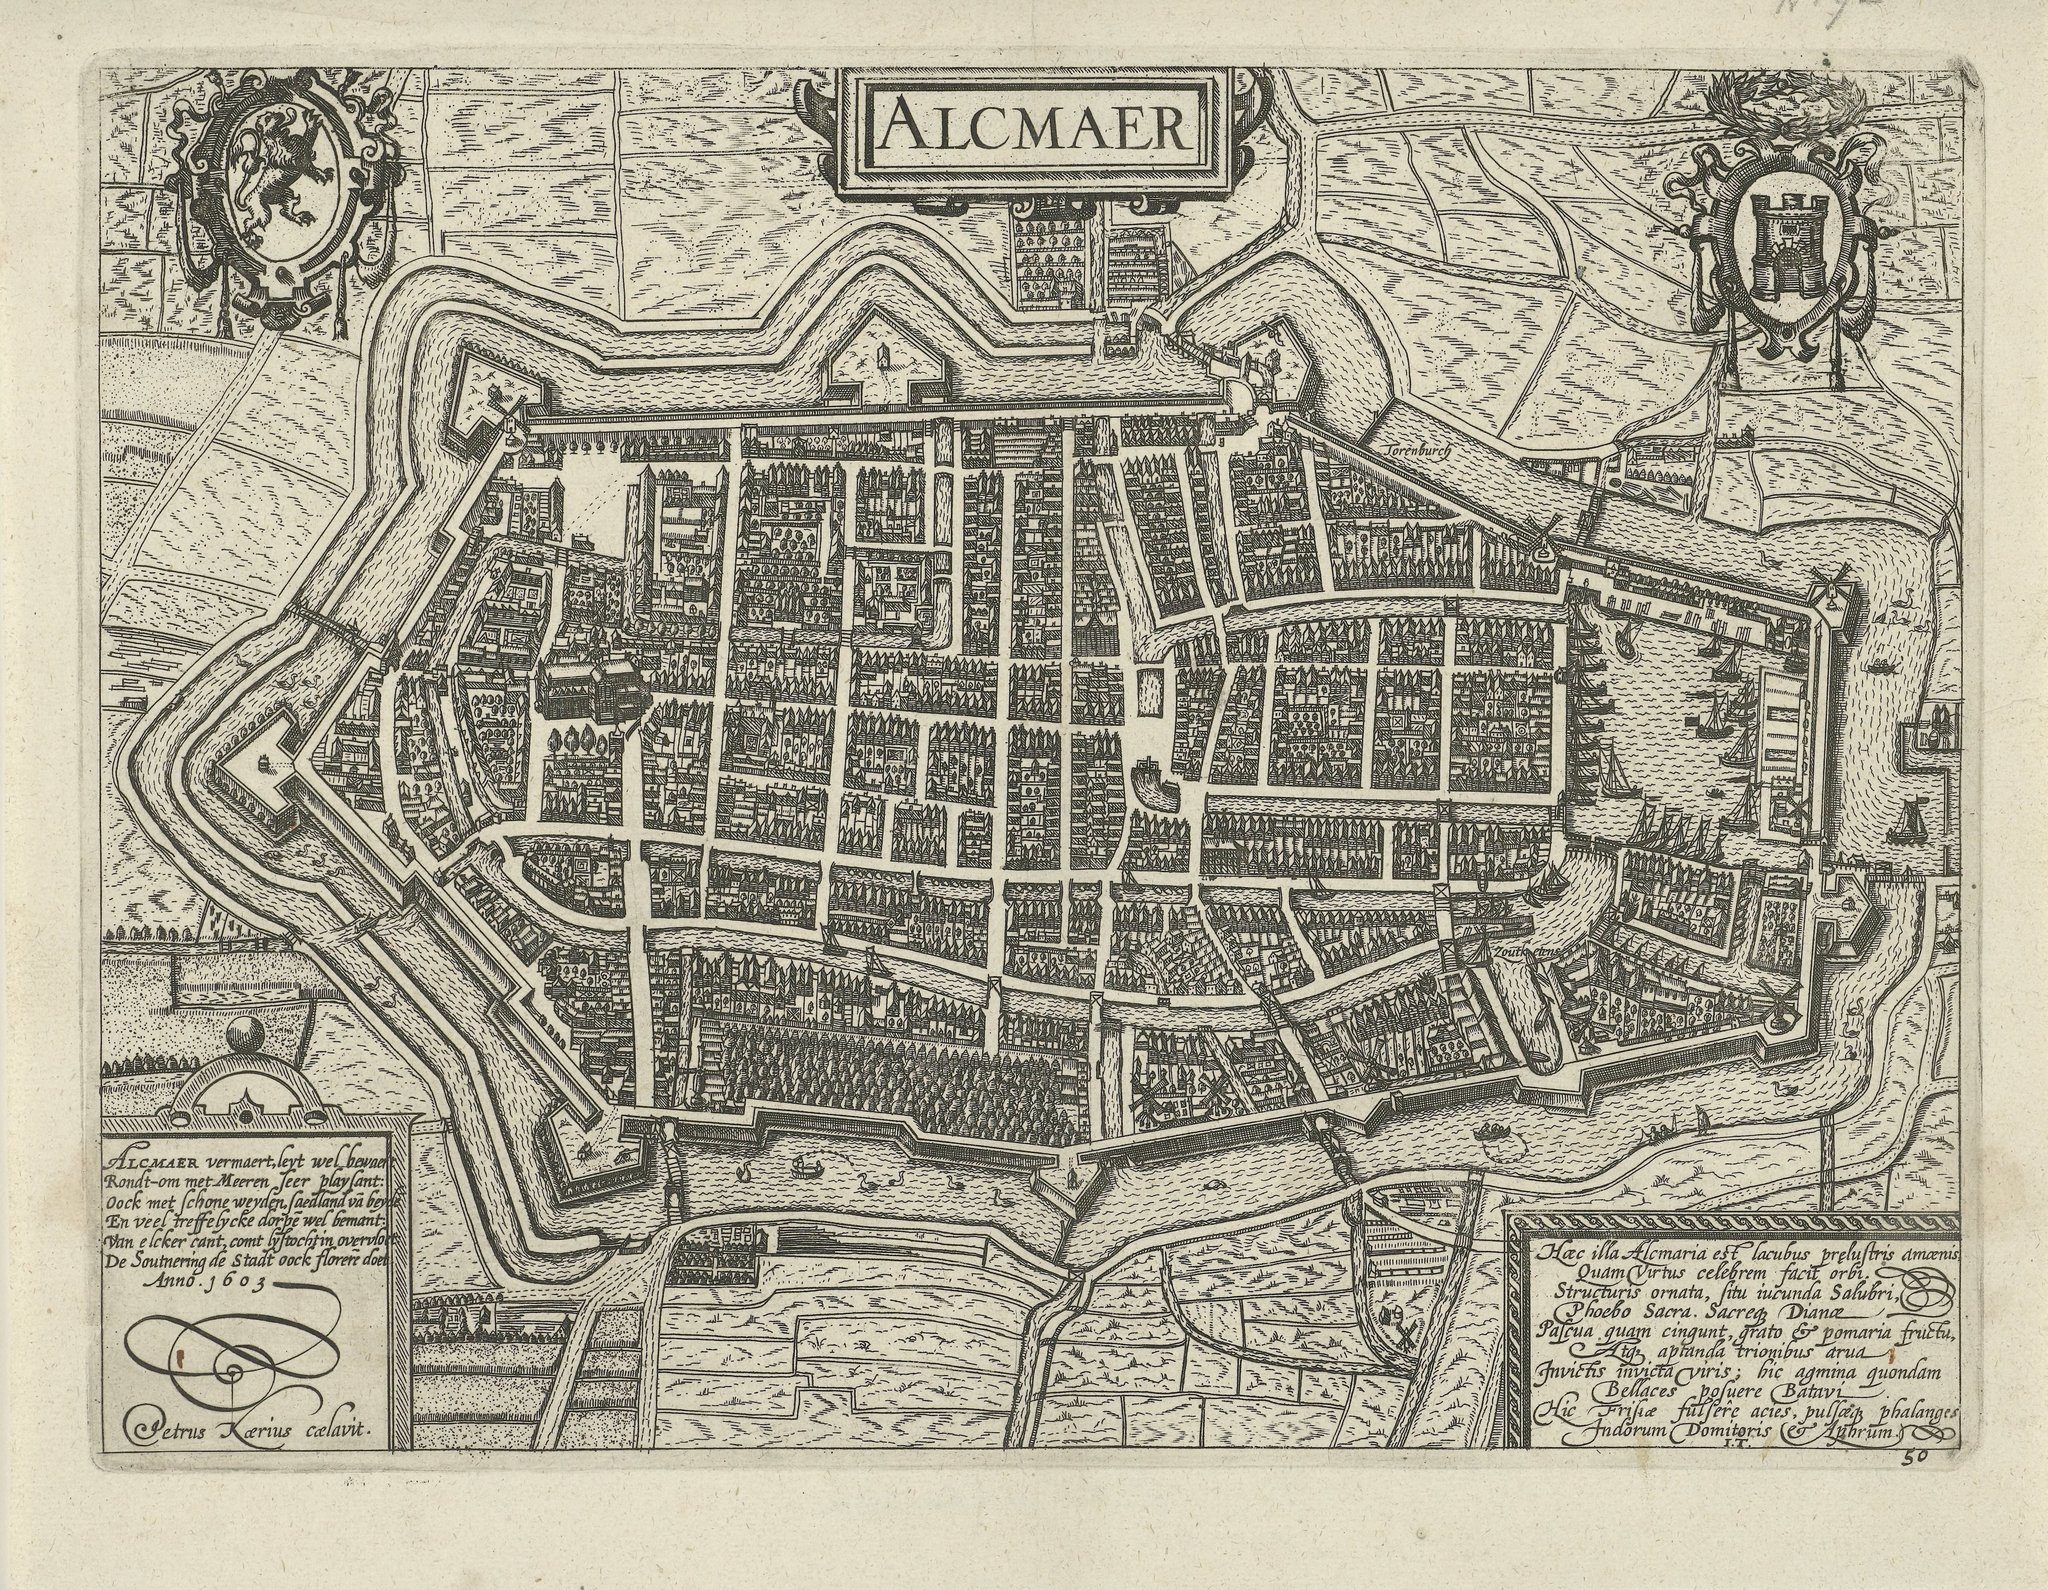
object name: area plan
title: Alcmaer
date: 1603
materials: paper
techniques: engraving, etching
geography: amsterdam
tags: coat of arms (as symbol of the state, etc.) (+ city; municipal), maps of cities, coat of arms (as symbol of the state, etc.) (+ province; provincial)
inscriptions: collector's mark: Lugt 2760, collector's mark: Lugt 2228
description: Plattegrond in vogelvluchtperspectief. Linksboven het wapen van Holland, in het midden een cartouche met de titel, rechtsboven het wapen van Alkmaar. Linksonder een cartouche met een lofdicht in het Nederlands. Rechtsonder een cartouche met een lofdicht in het Latijn. Rechtsonder in de marge genummerd: 50.